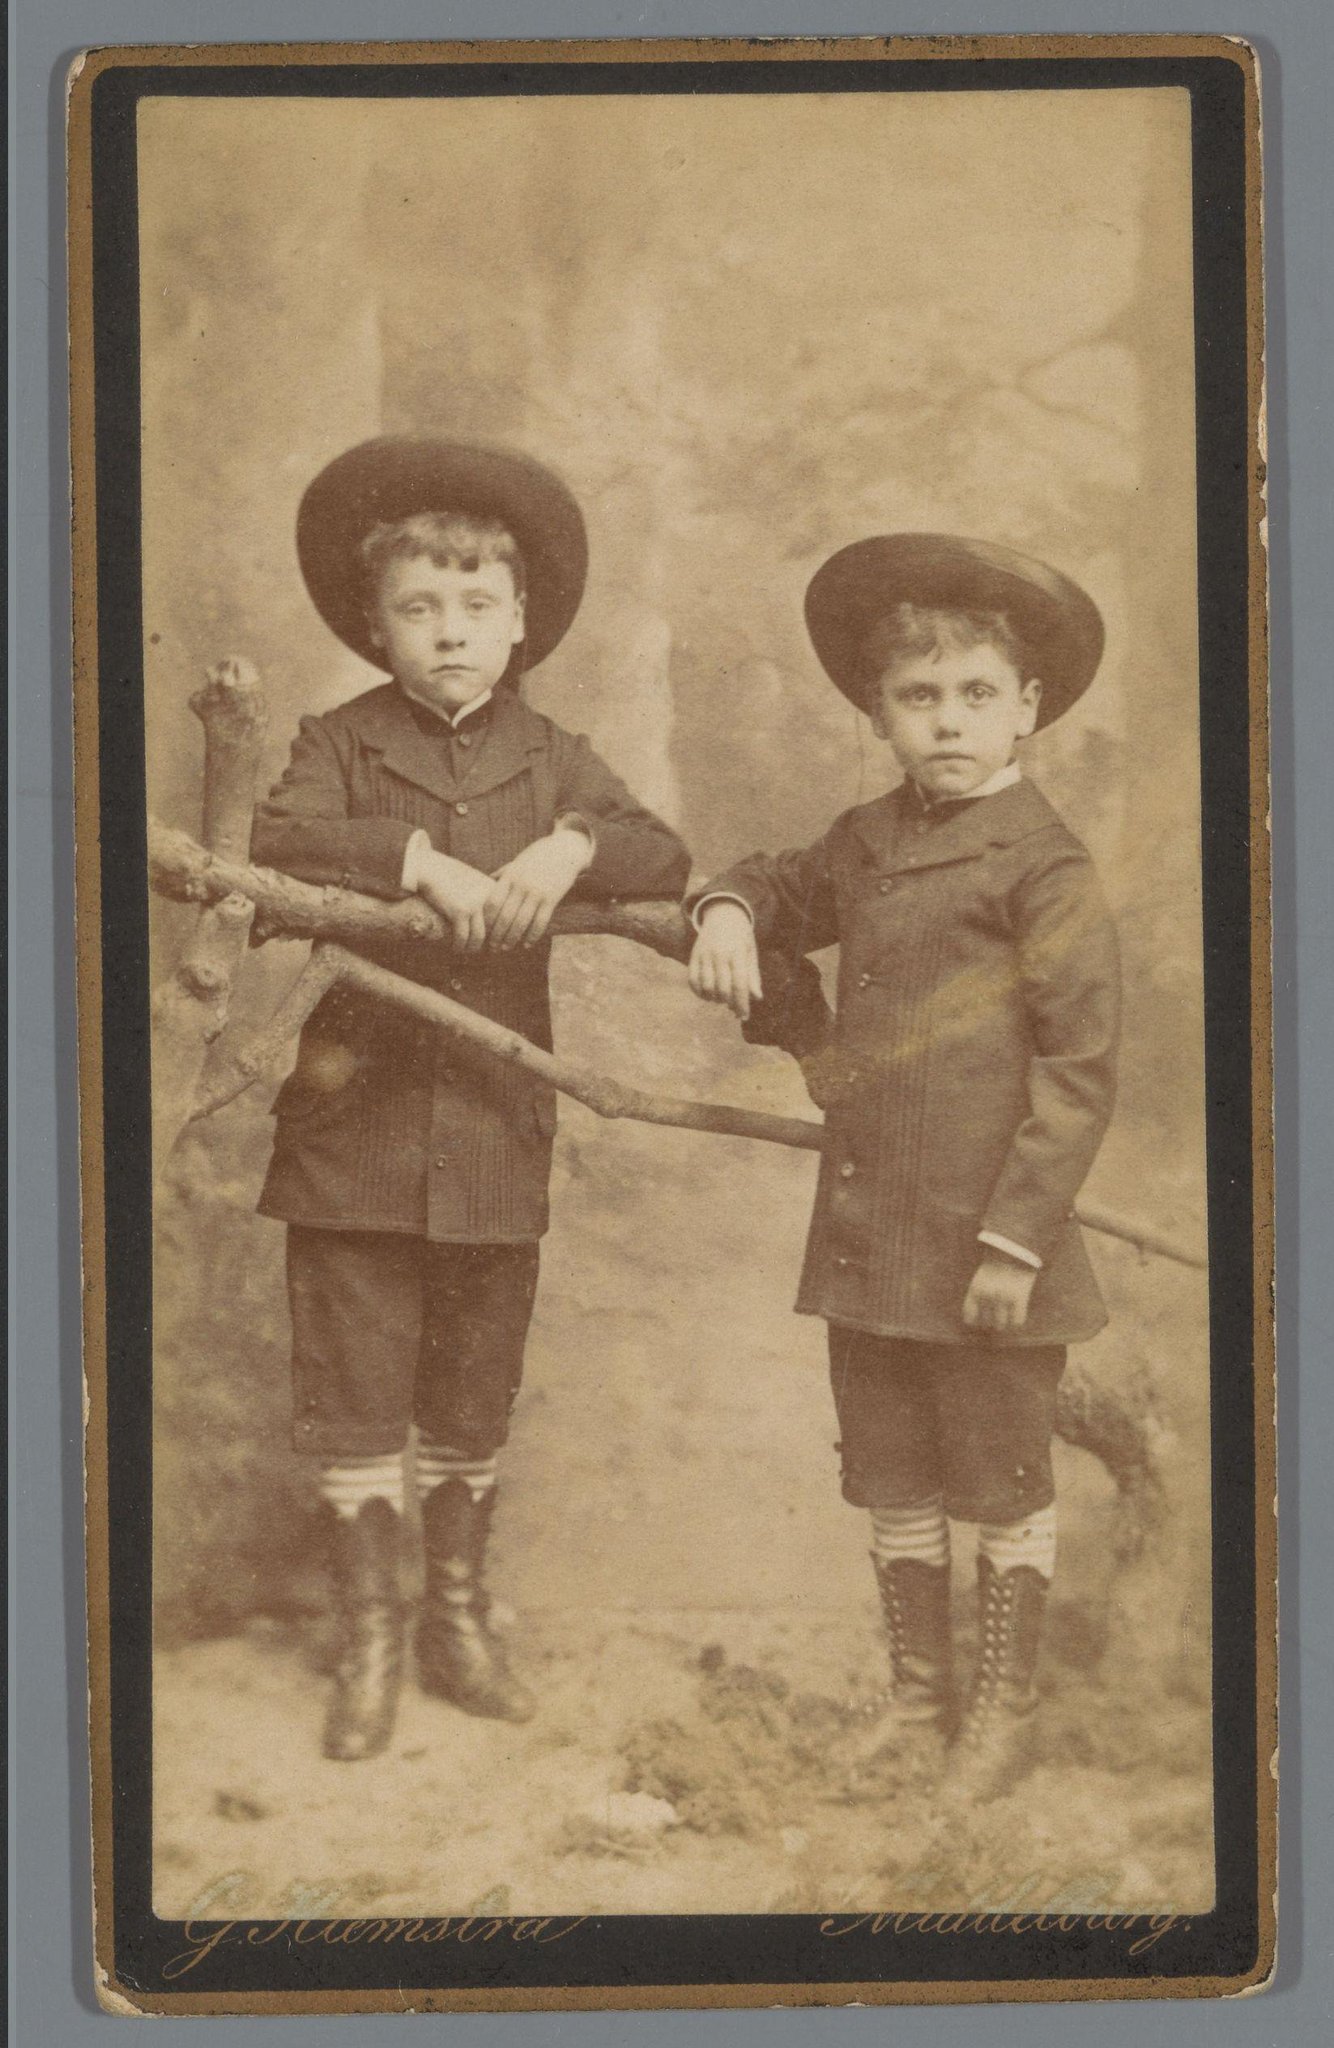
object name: carte de visite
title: Portret van twee onbekende jongens met hoeden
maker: gerben hiemstra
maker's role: fotograaf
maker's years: 1854-1907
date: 1880-1891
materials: cardboard, paper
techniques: albumen print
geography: middelburg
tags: boy (child between toddler and youth), head-gear: hat, anonymous historical person portrayed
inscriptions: inscription: ‘Firma: J. Korsten/ MIDDELBURG/ Speciale inrichting voor vergrootingen./ De plaat blijft ter nabestelling bewaard.’